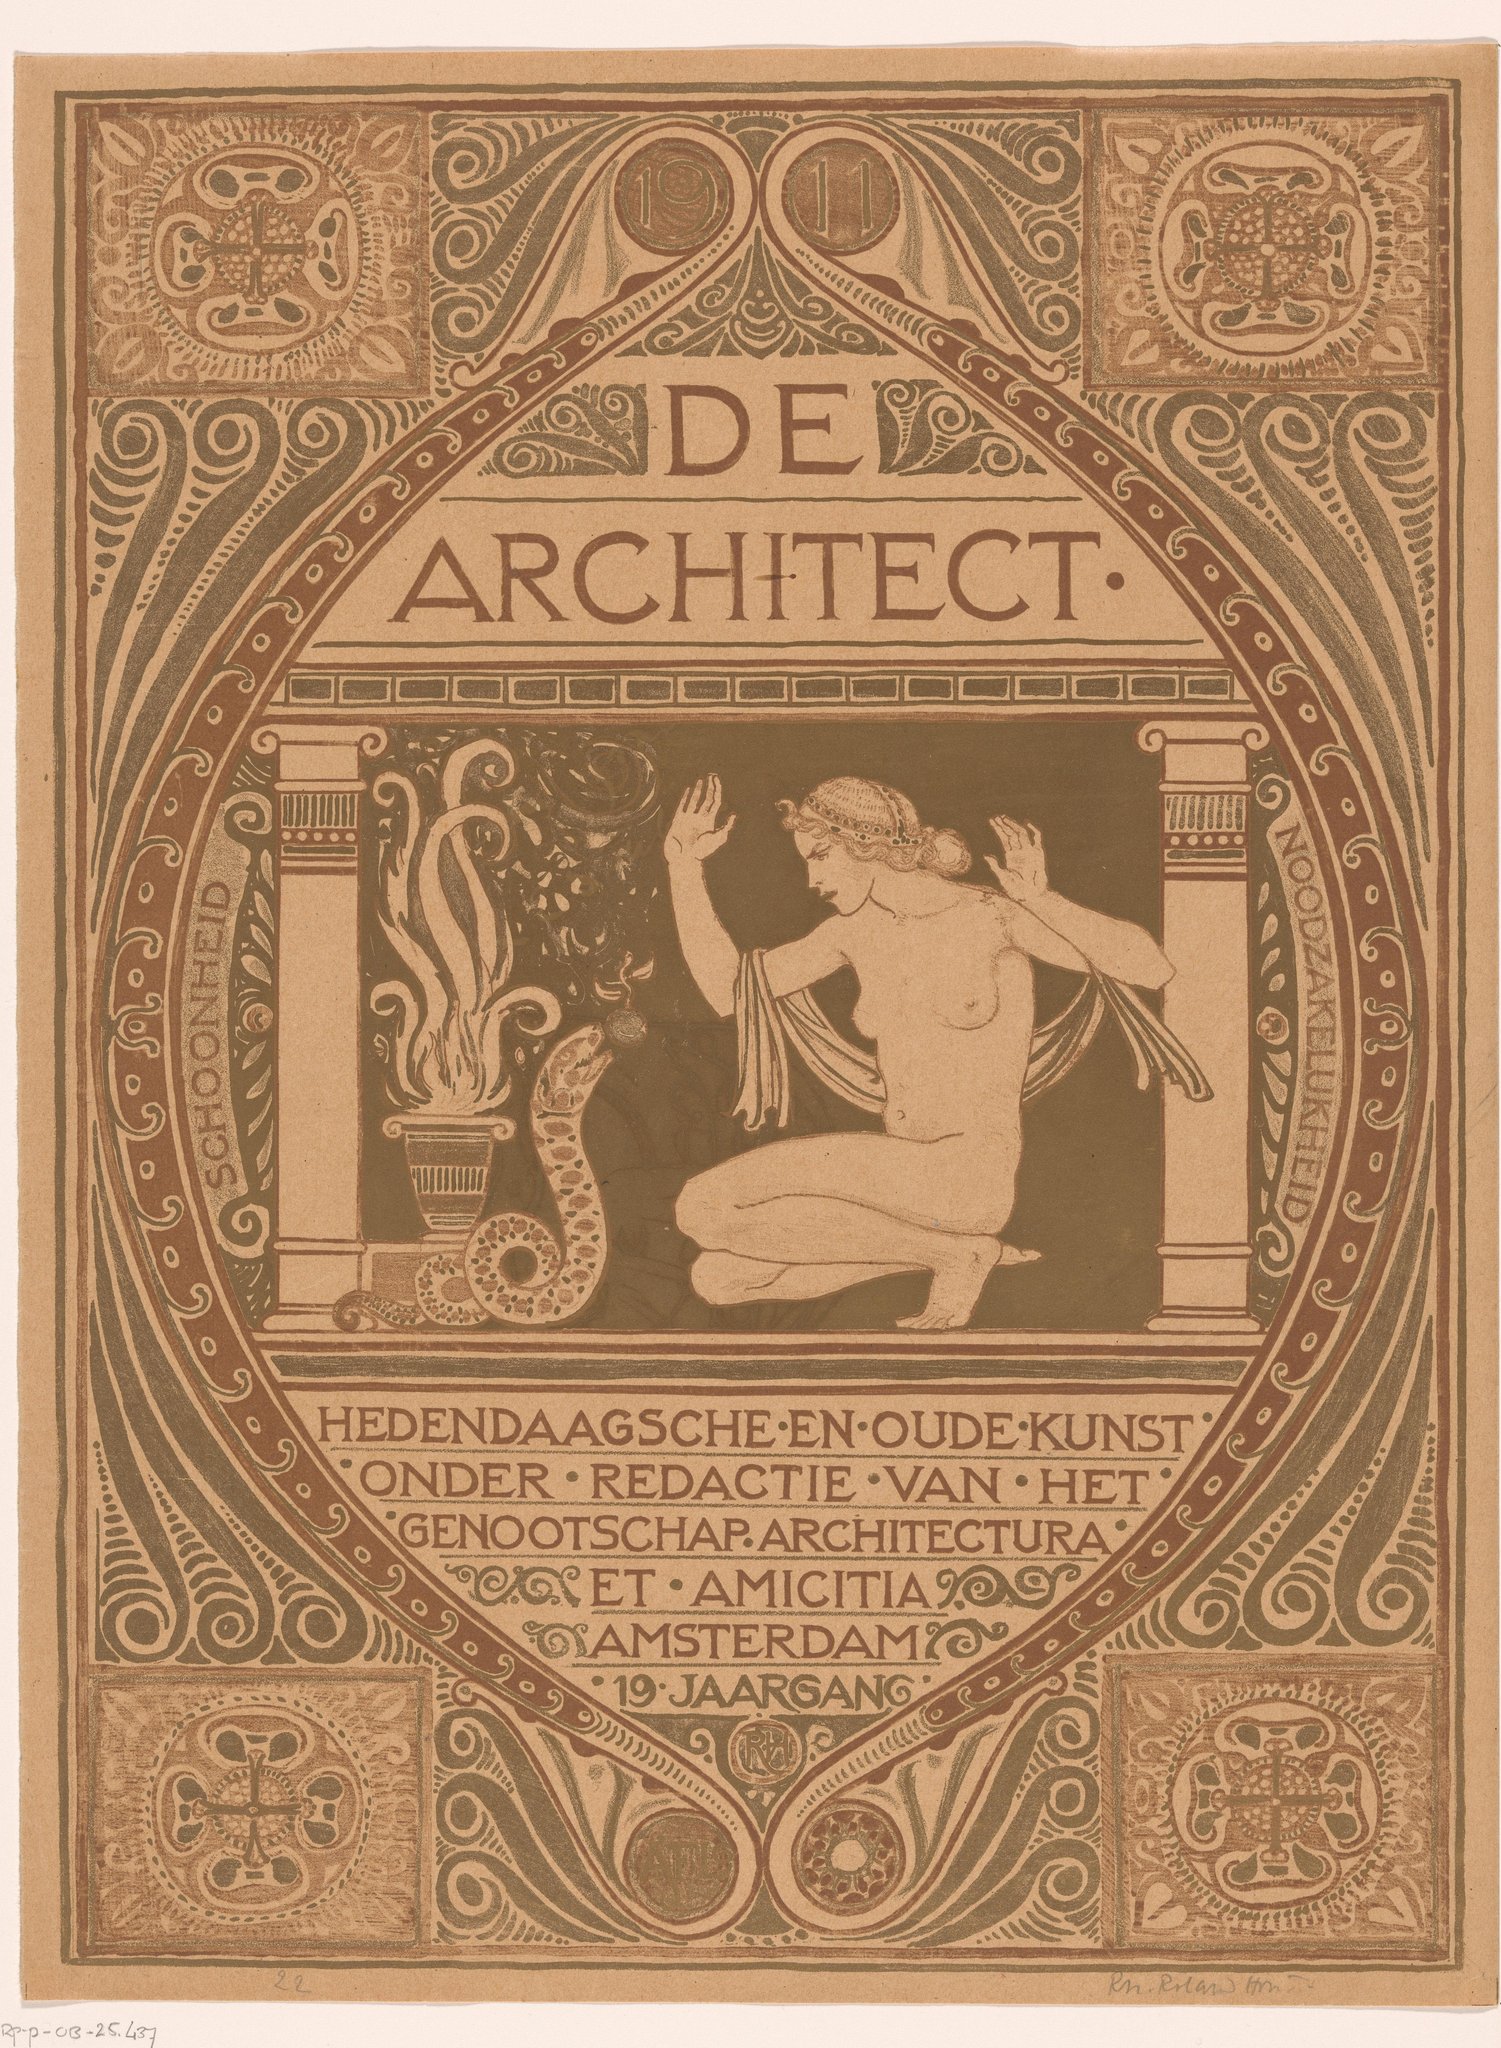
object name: wrapper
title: Omslagontwerp voor: De Architect, 1911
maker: richard nicolaüs roland holst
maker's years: 1868-1938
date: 1911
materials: paper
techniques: lithograph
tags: snakes, kneeling figure - aa - female human figure, column, pillar ~ architecture, open fire (in general), woman (showing herself) undressed, quasi-nude, fruits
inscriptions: collector's mark: Lugt 2228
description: Een rechthoekig kader met daarin een naakte vrouw die knielt bij een slang die een vrucht in zijn bek heeft. De vrouw houdt haar armen in de lucht. Op de achtergrond twee zuilen en een vuur. Links het woord 'SCHOONHEID', rechts het woord 'NOODZAKELIJKHEID'.